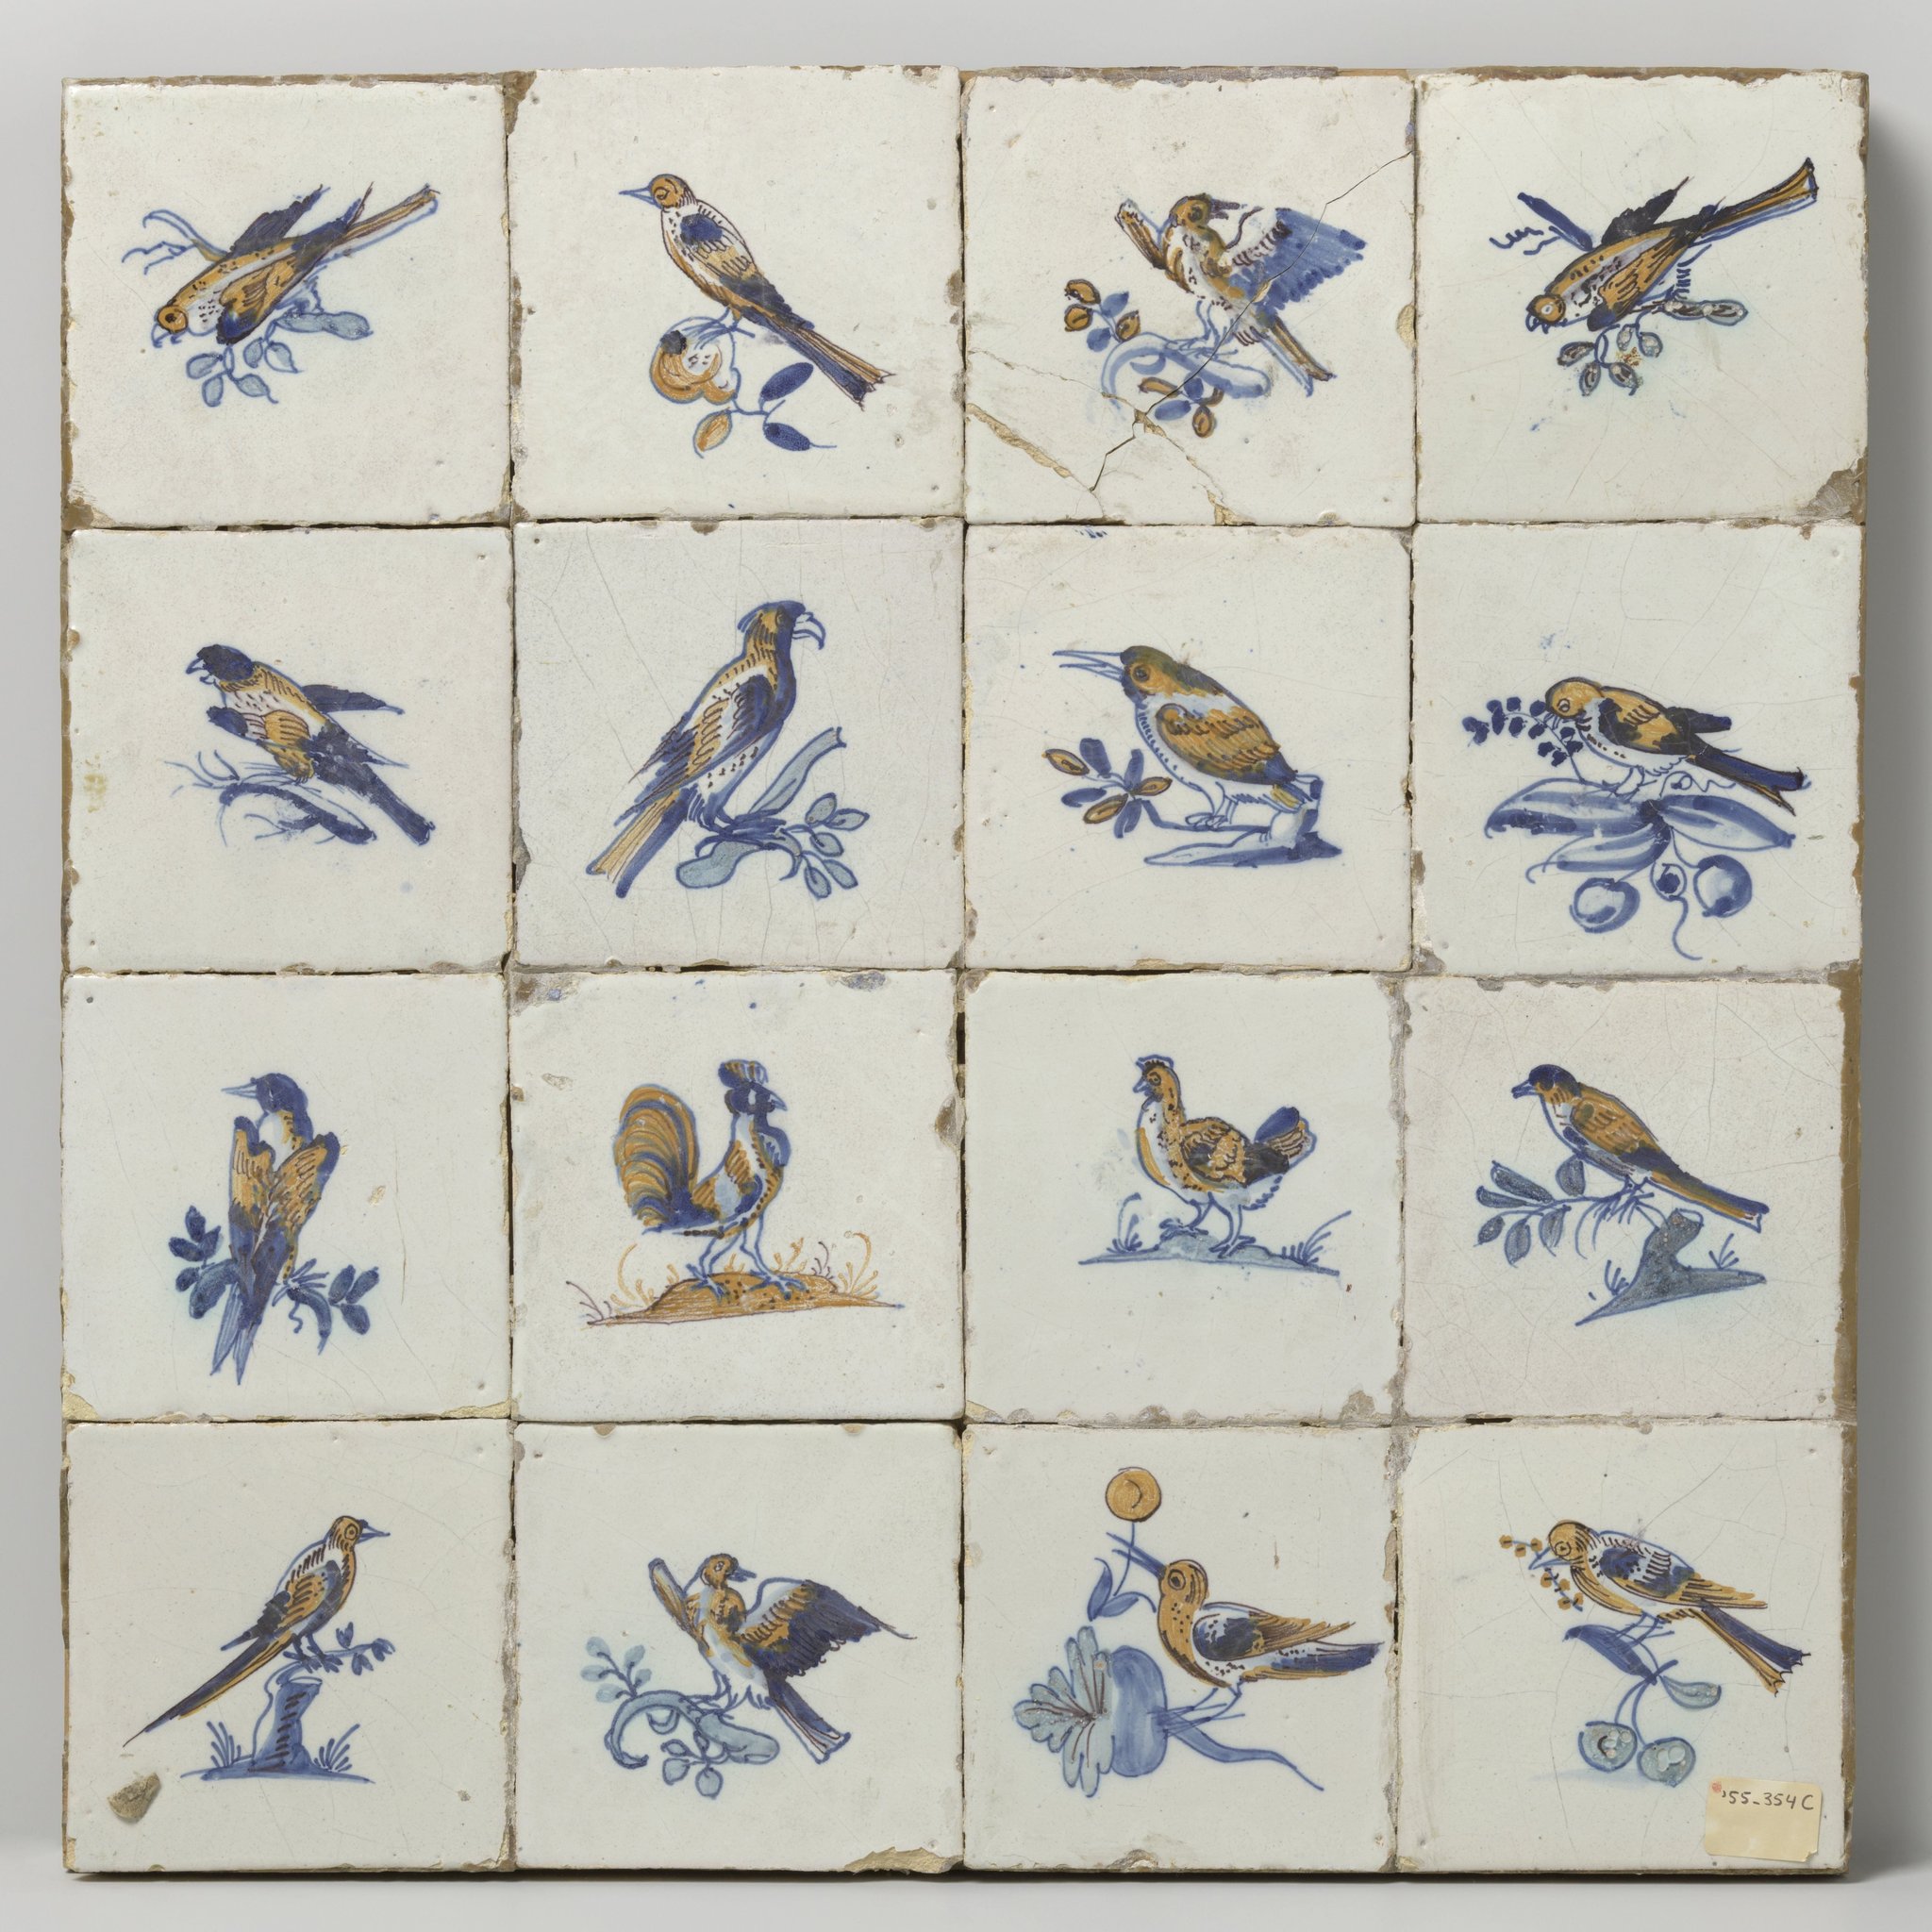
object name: vogeltegel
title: Veld van zestien tegels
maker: Anonymous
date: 1650-1700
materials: earthenware, glaze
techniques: maiolica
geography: netherlands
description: Veld van zestien tegels (4 x 4) elk met een veelkleurig (blauw, oranje en paars) geschilderde vogel op een tak met besjes of op een grond.